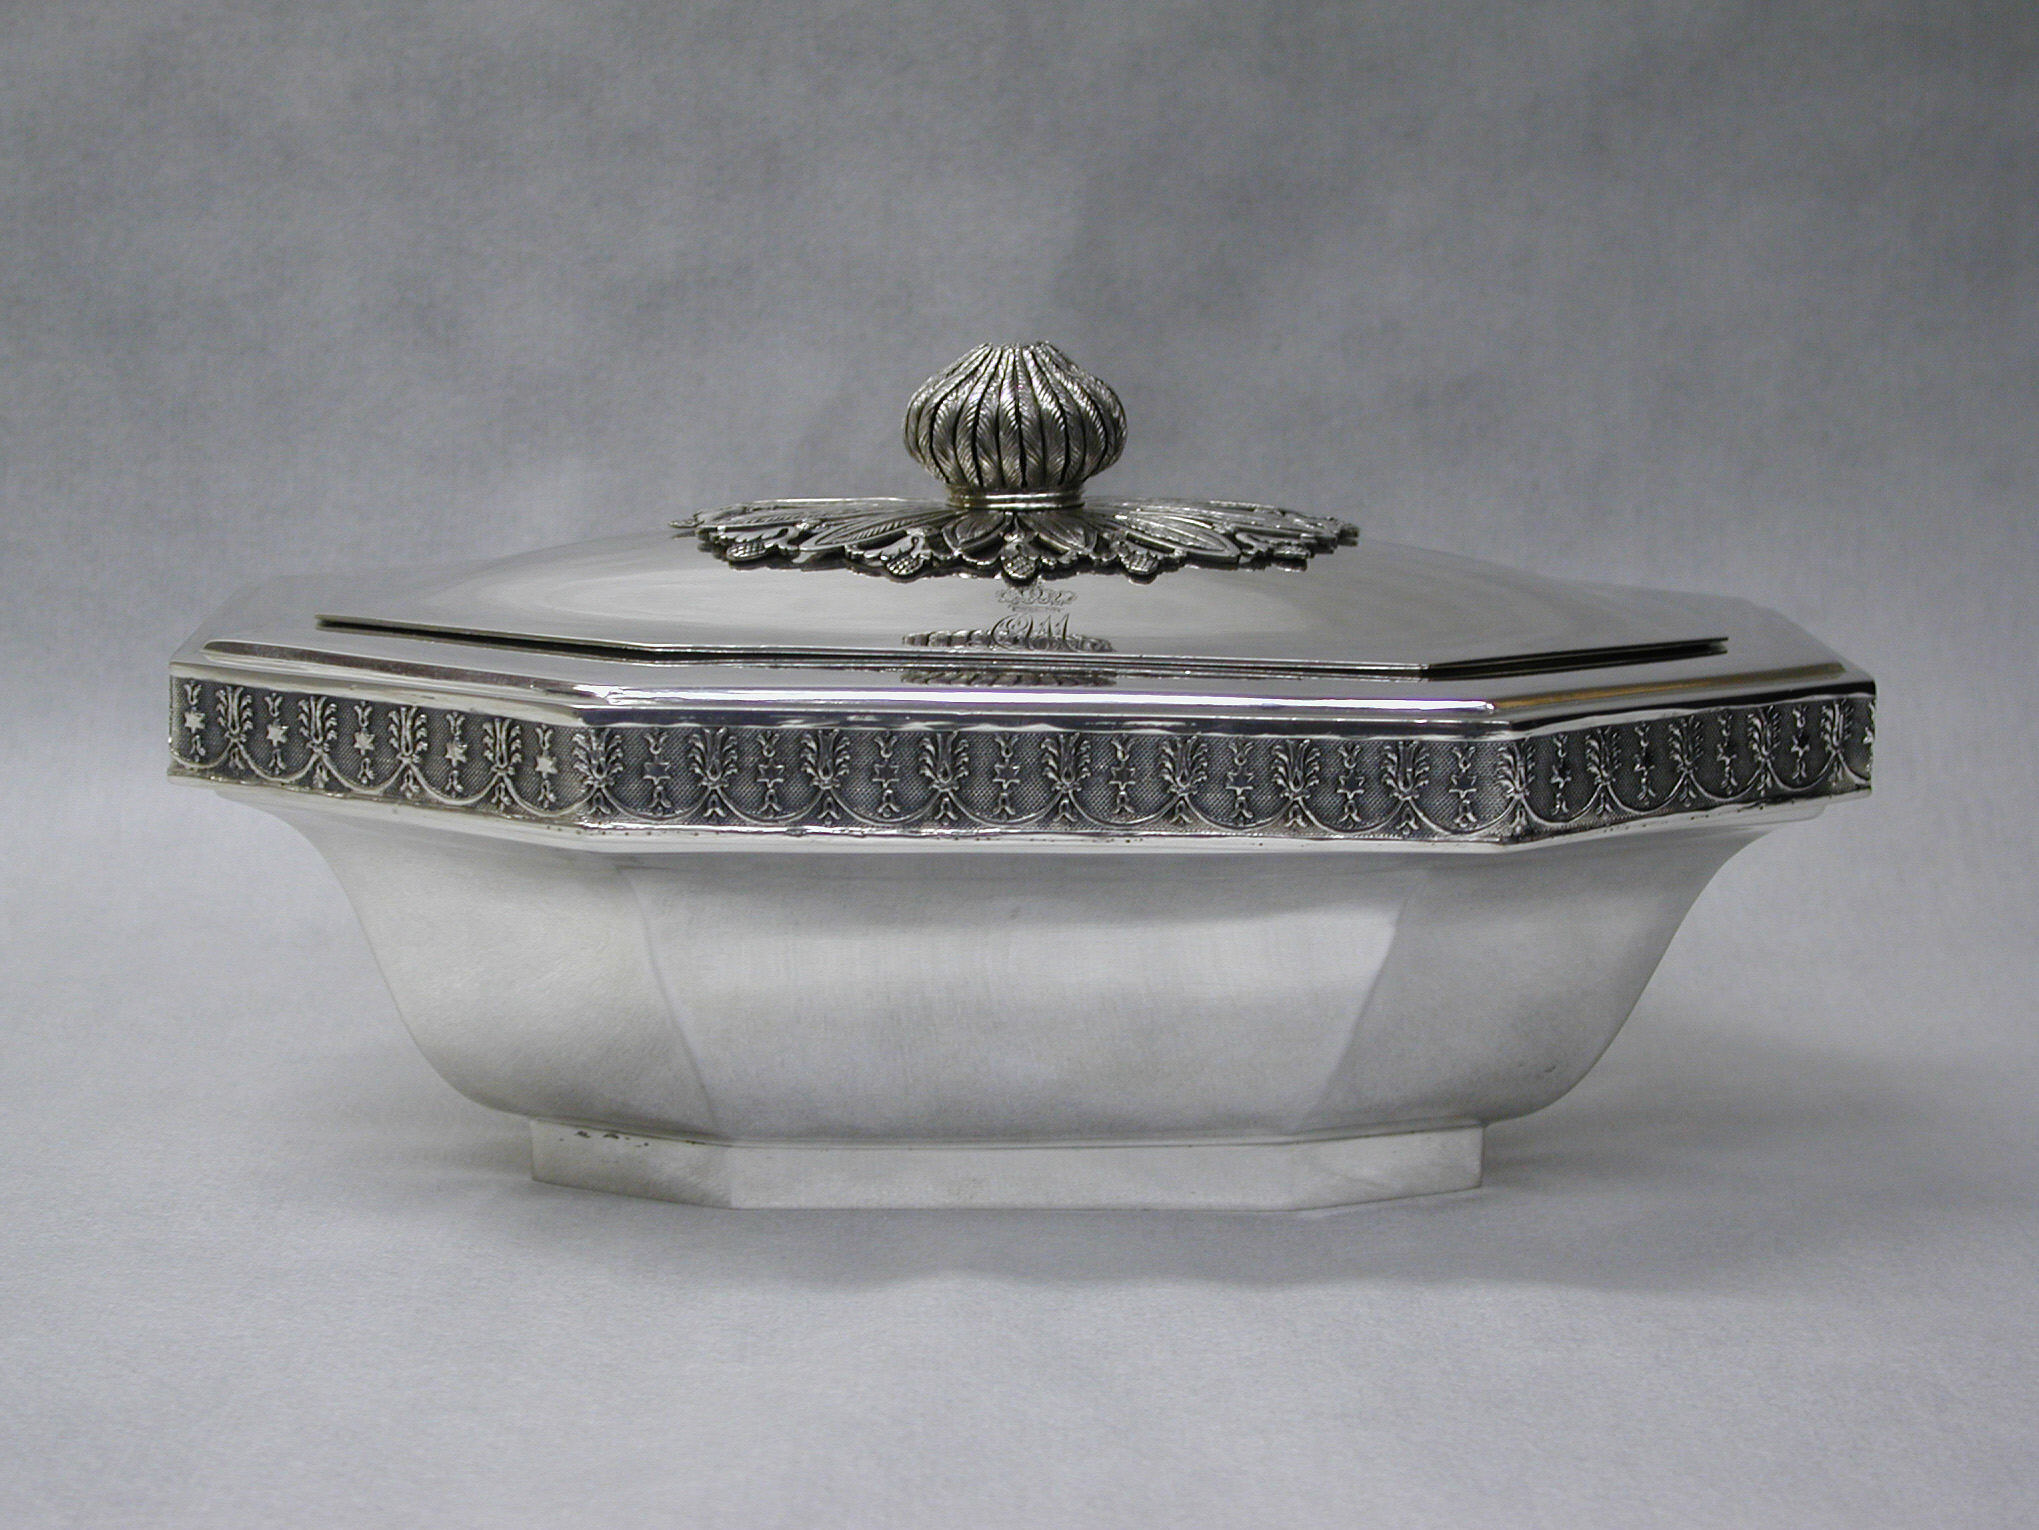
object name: box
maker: johann christian sick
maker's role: maker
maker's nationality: german (stuttgart)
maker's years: 1766-1824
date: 1800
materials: silver